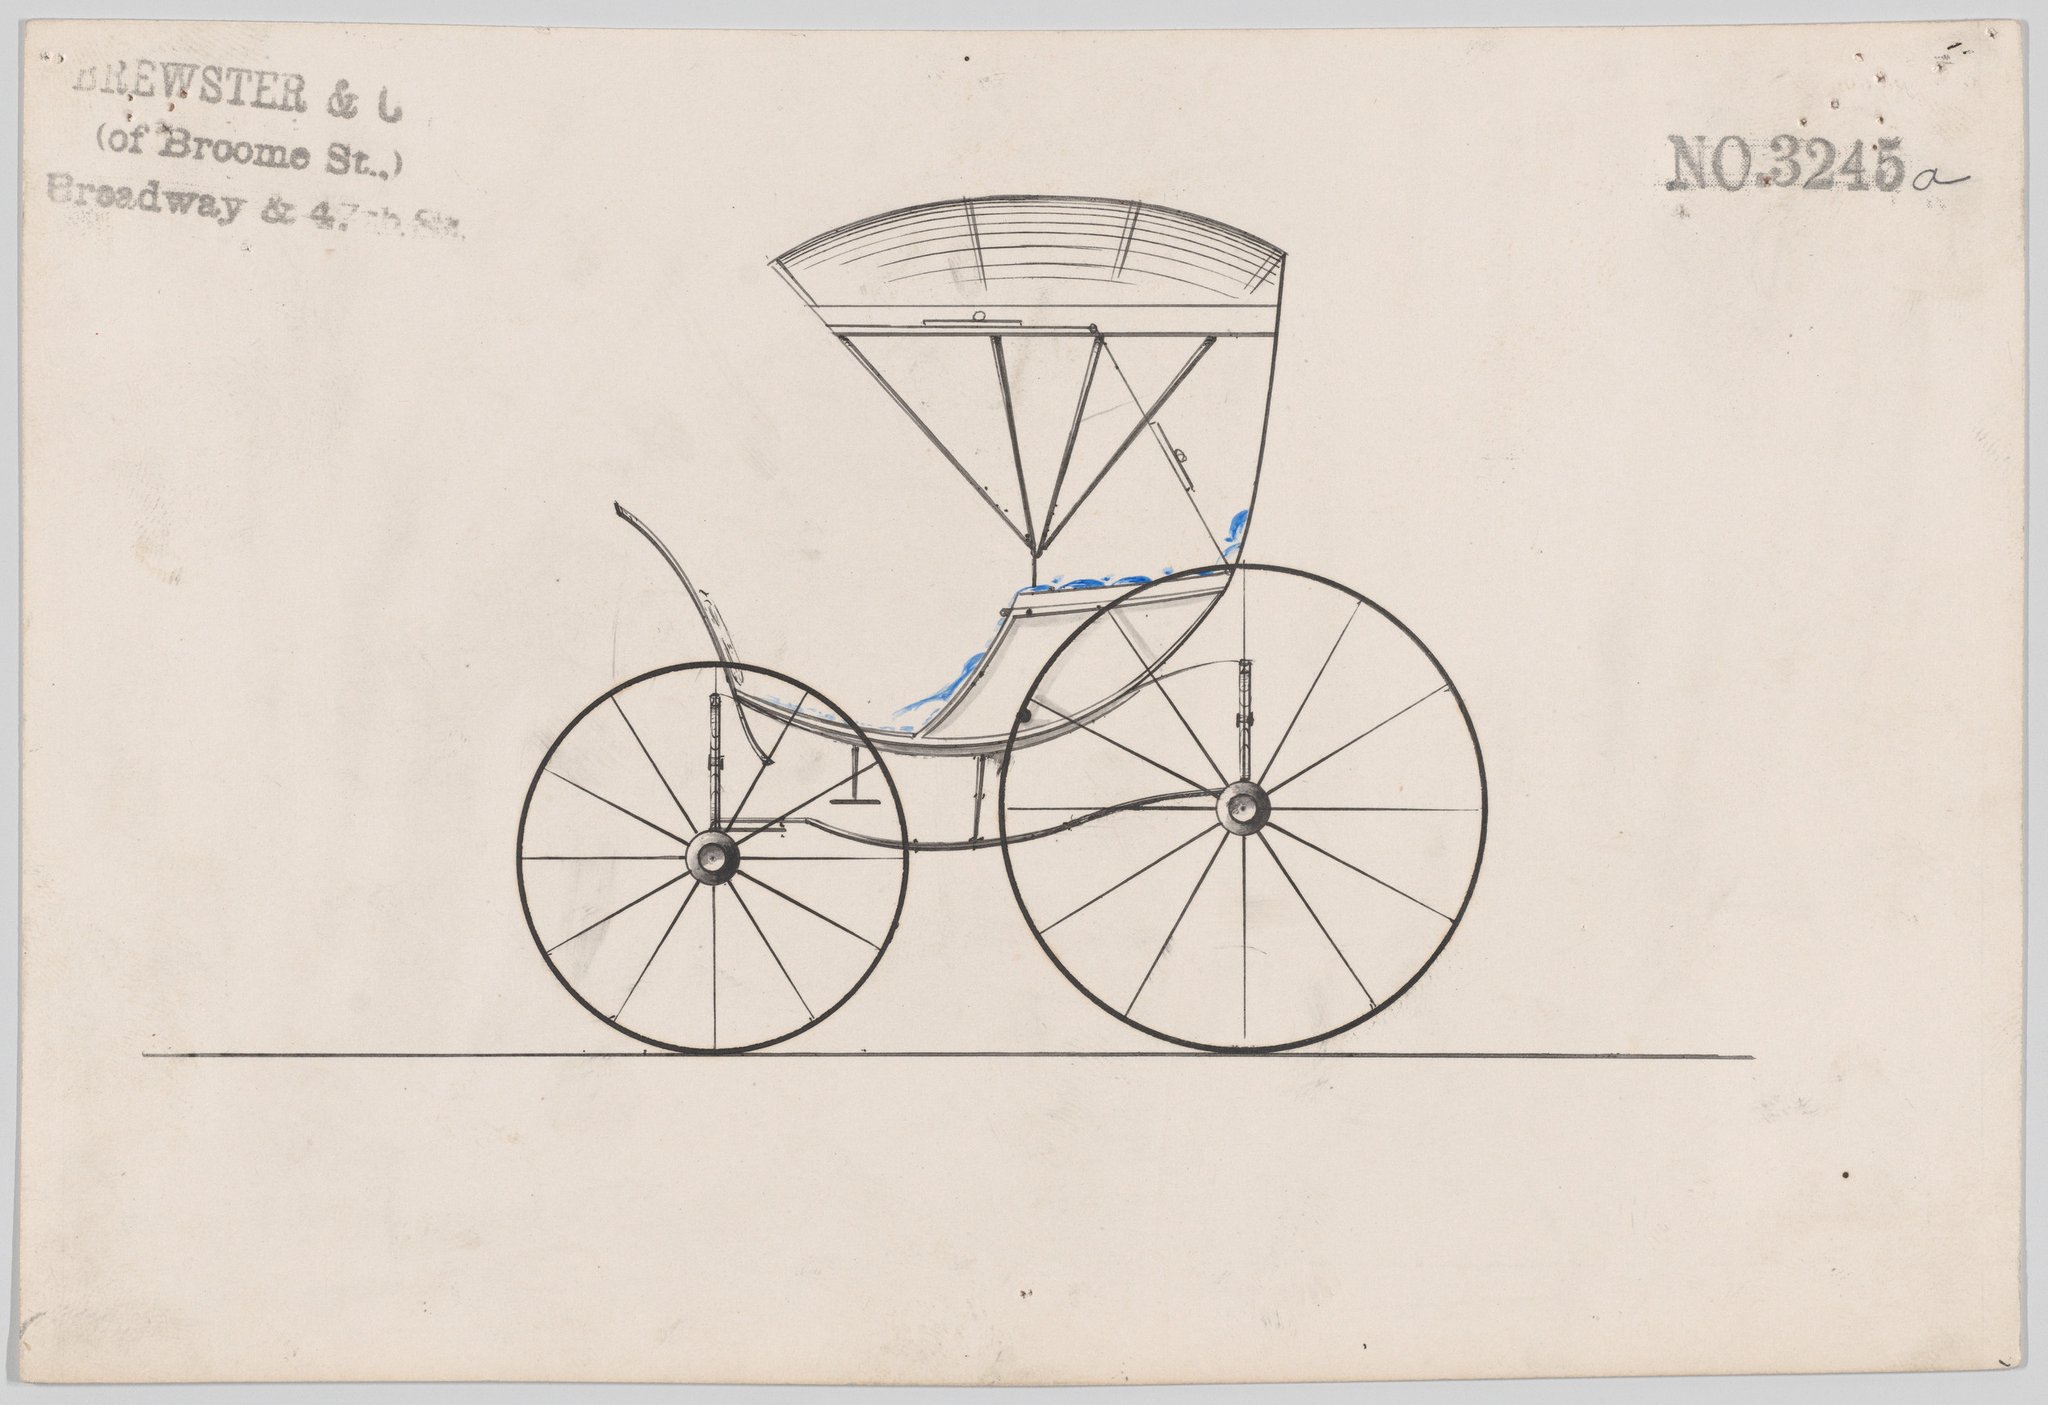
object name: drawing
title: Design for Pony Phaeton, no. 3245a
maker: brewster & co.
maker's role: manufacturer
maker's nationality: american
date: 1876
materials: ink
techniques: pen, wash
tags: carriages